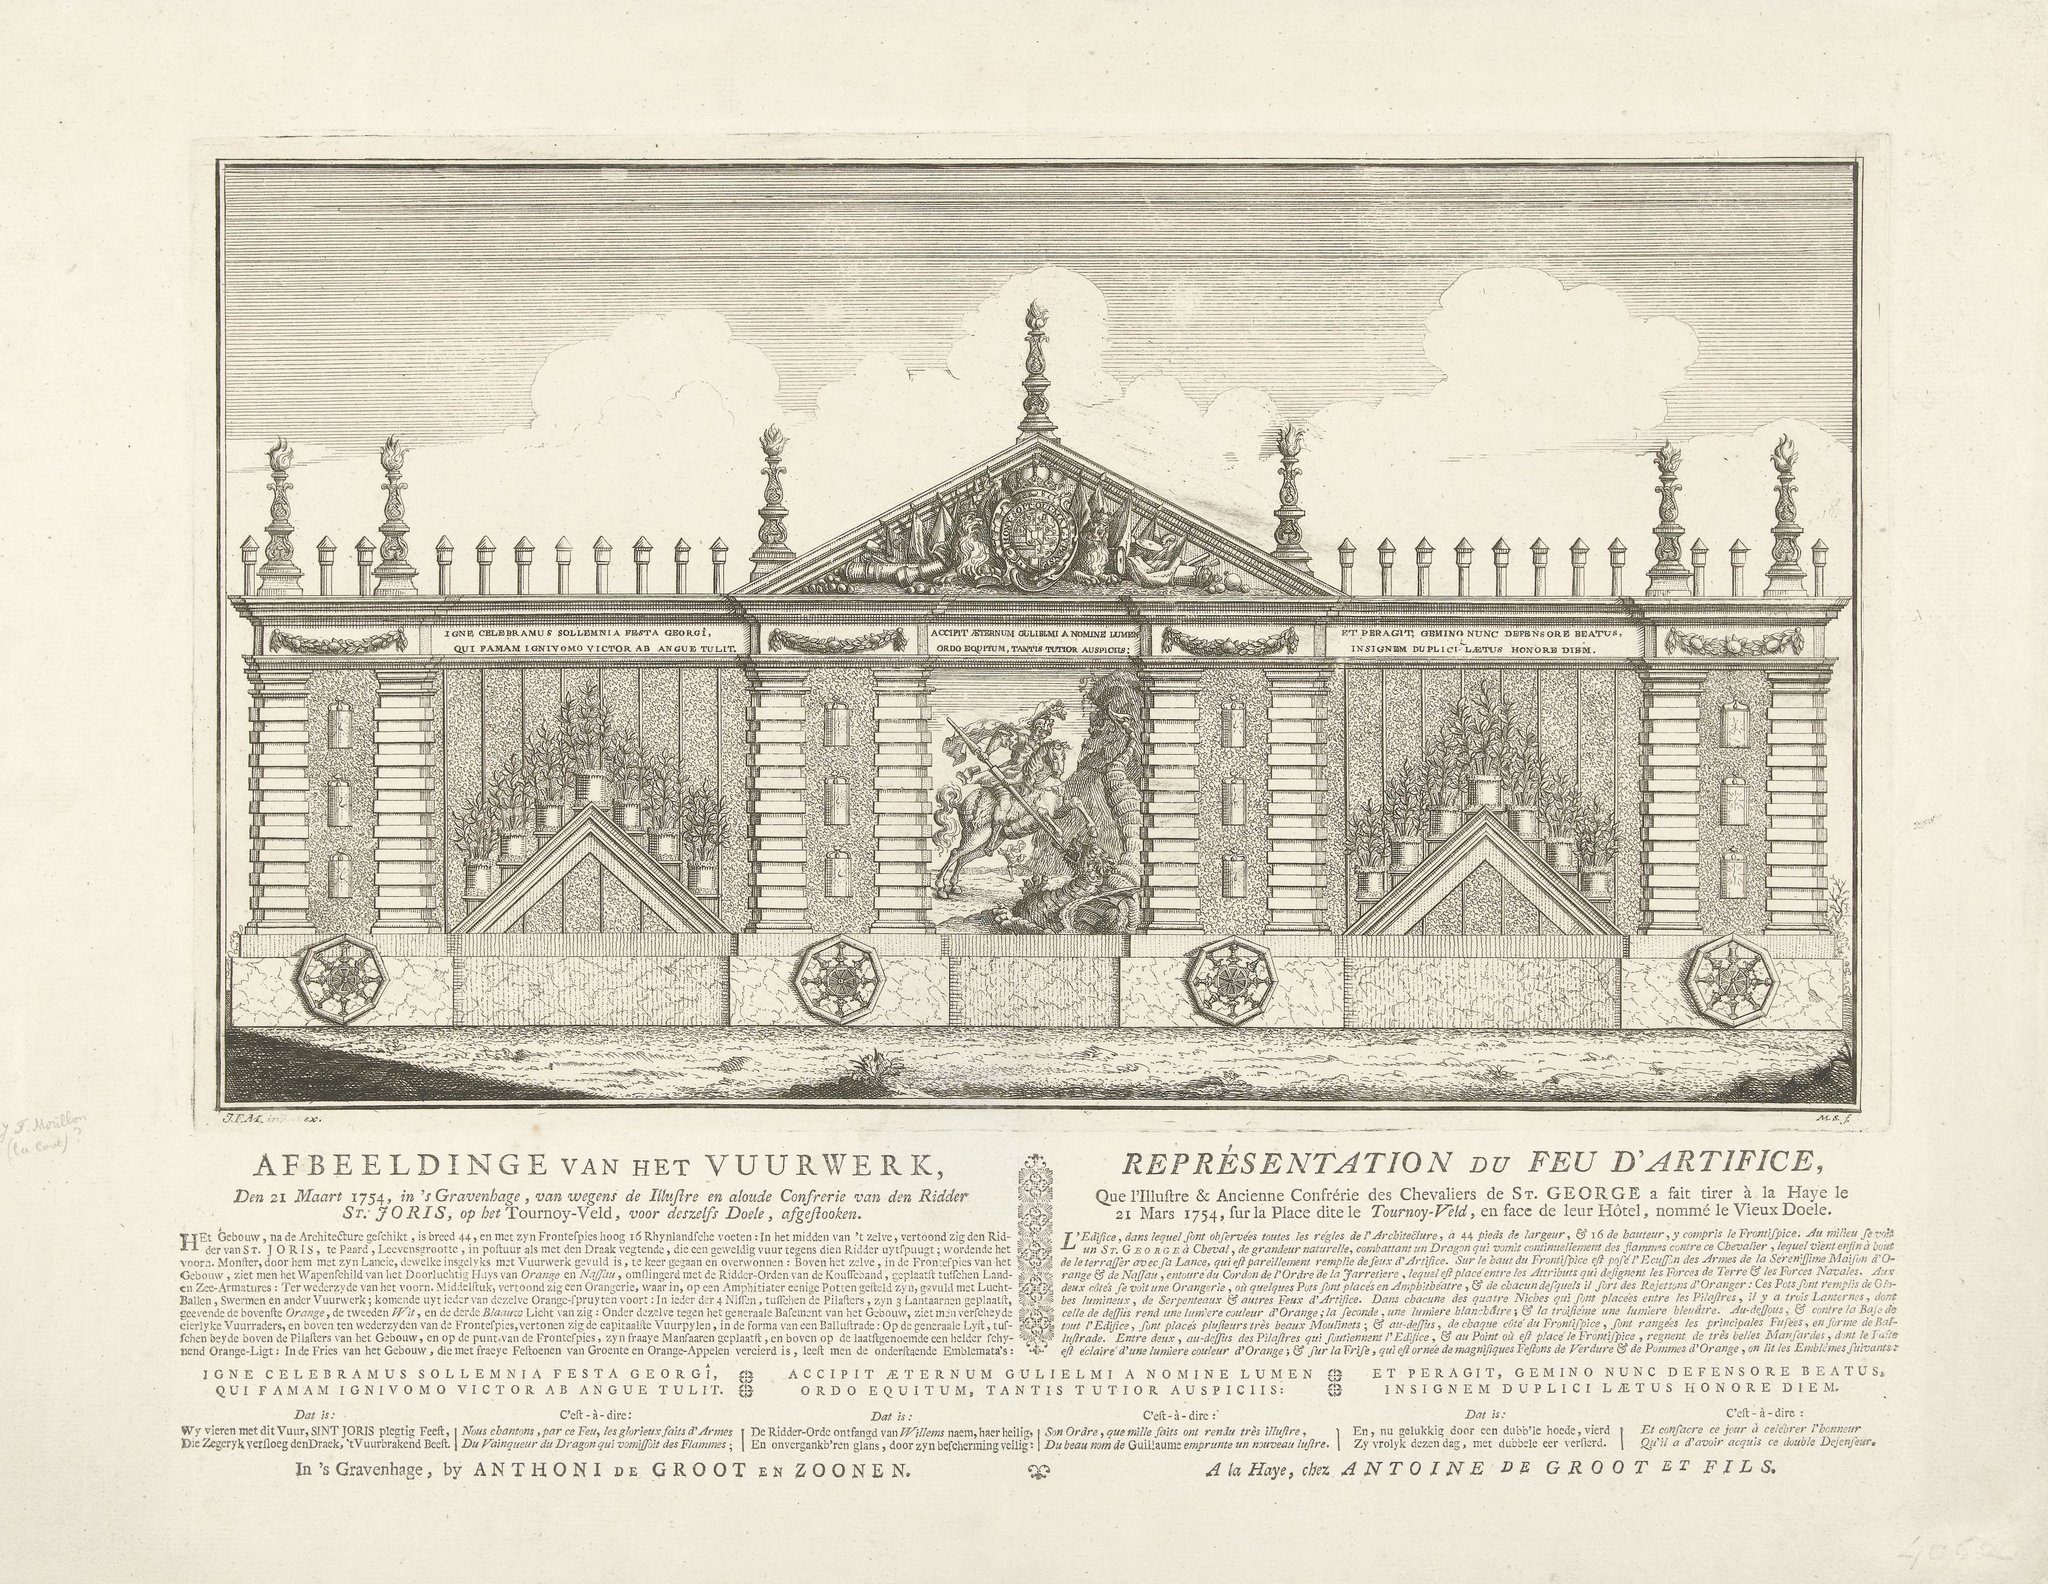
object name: print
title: Afbeeldinge van het Vuurwerk, Den 21 Maart 1754, in 's Gravenhage, van wegens de Illustre en aloude Confrerie van den Ridder St. Joris, op het Tournoy-Veld, voor deszelfs Doele, afgestooken / Représentation du Feu D'Artifice (...)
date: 1754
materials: paper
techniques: engraving, etching, letterpress printing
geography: the hague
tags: william v (prince of orange), knighthood order, bonfire, fire-works (+ illumination, fire-works ~ festive activities), the hague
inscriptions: collector's mark: Lugt 2166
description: Stellage voor het vuurwerk afgestoken op het toernooiveld bij de Sint-Jorisdoelen te 's-Gravenhage ter gelegenheid van de verheffing van prins Willem V tot Ridder in de Ridderorde van Sint Joris, 21 maart 1754. Centraal op de stellage een voorstelling van de heilige Joris die de draak verslaat, links en rechts potten met oranjetakken. Op het blad onder de plaat een beschrijving van de stellage in het Nederlands en Frans.